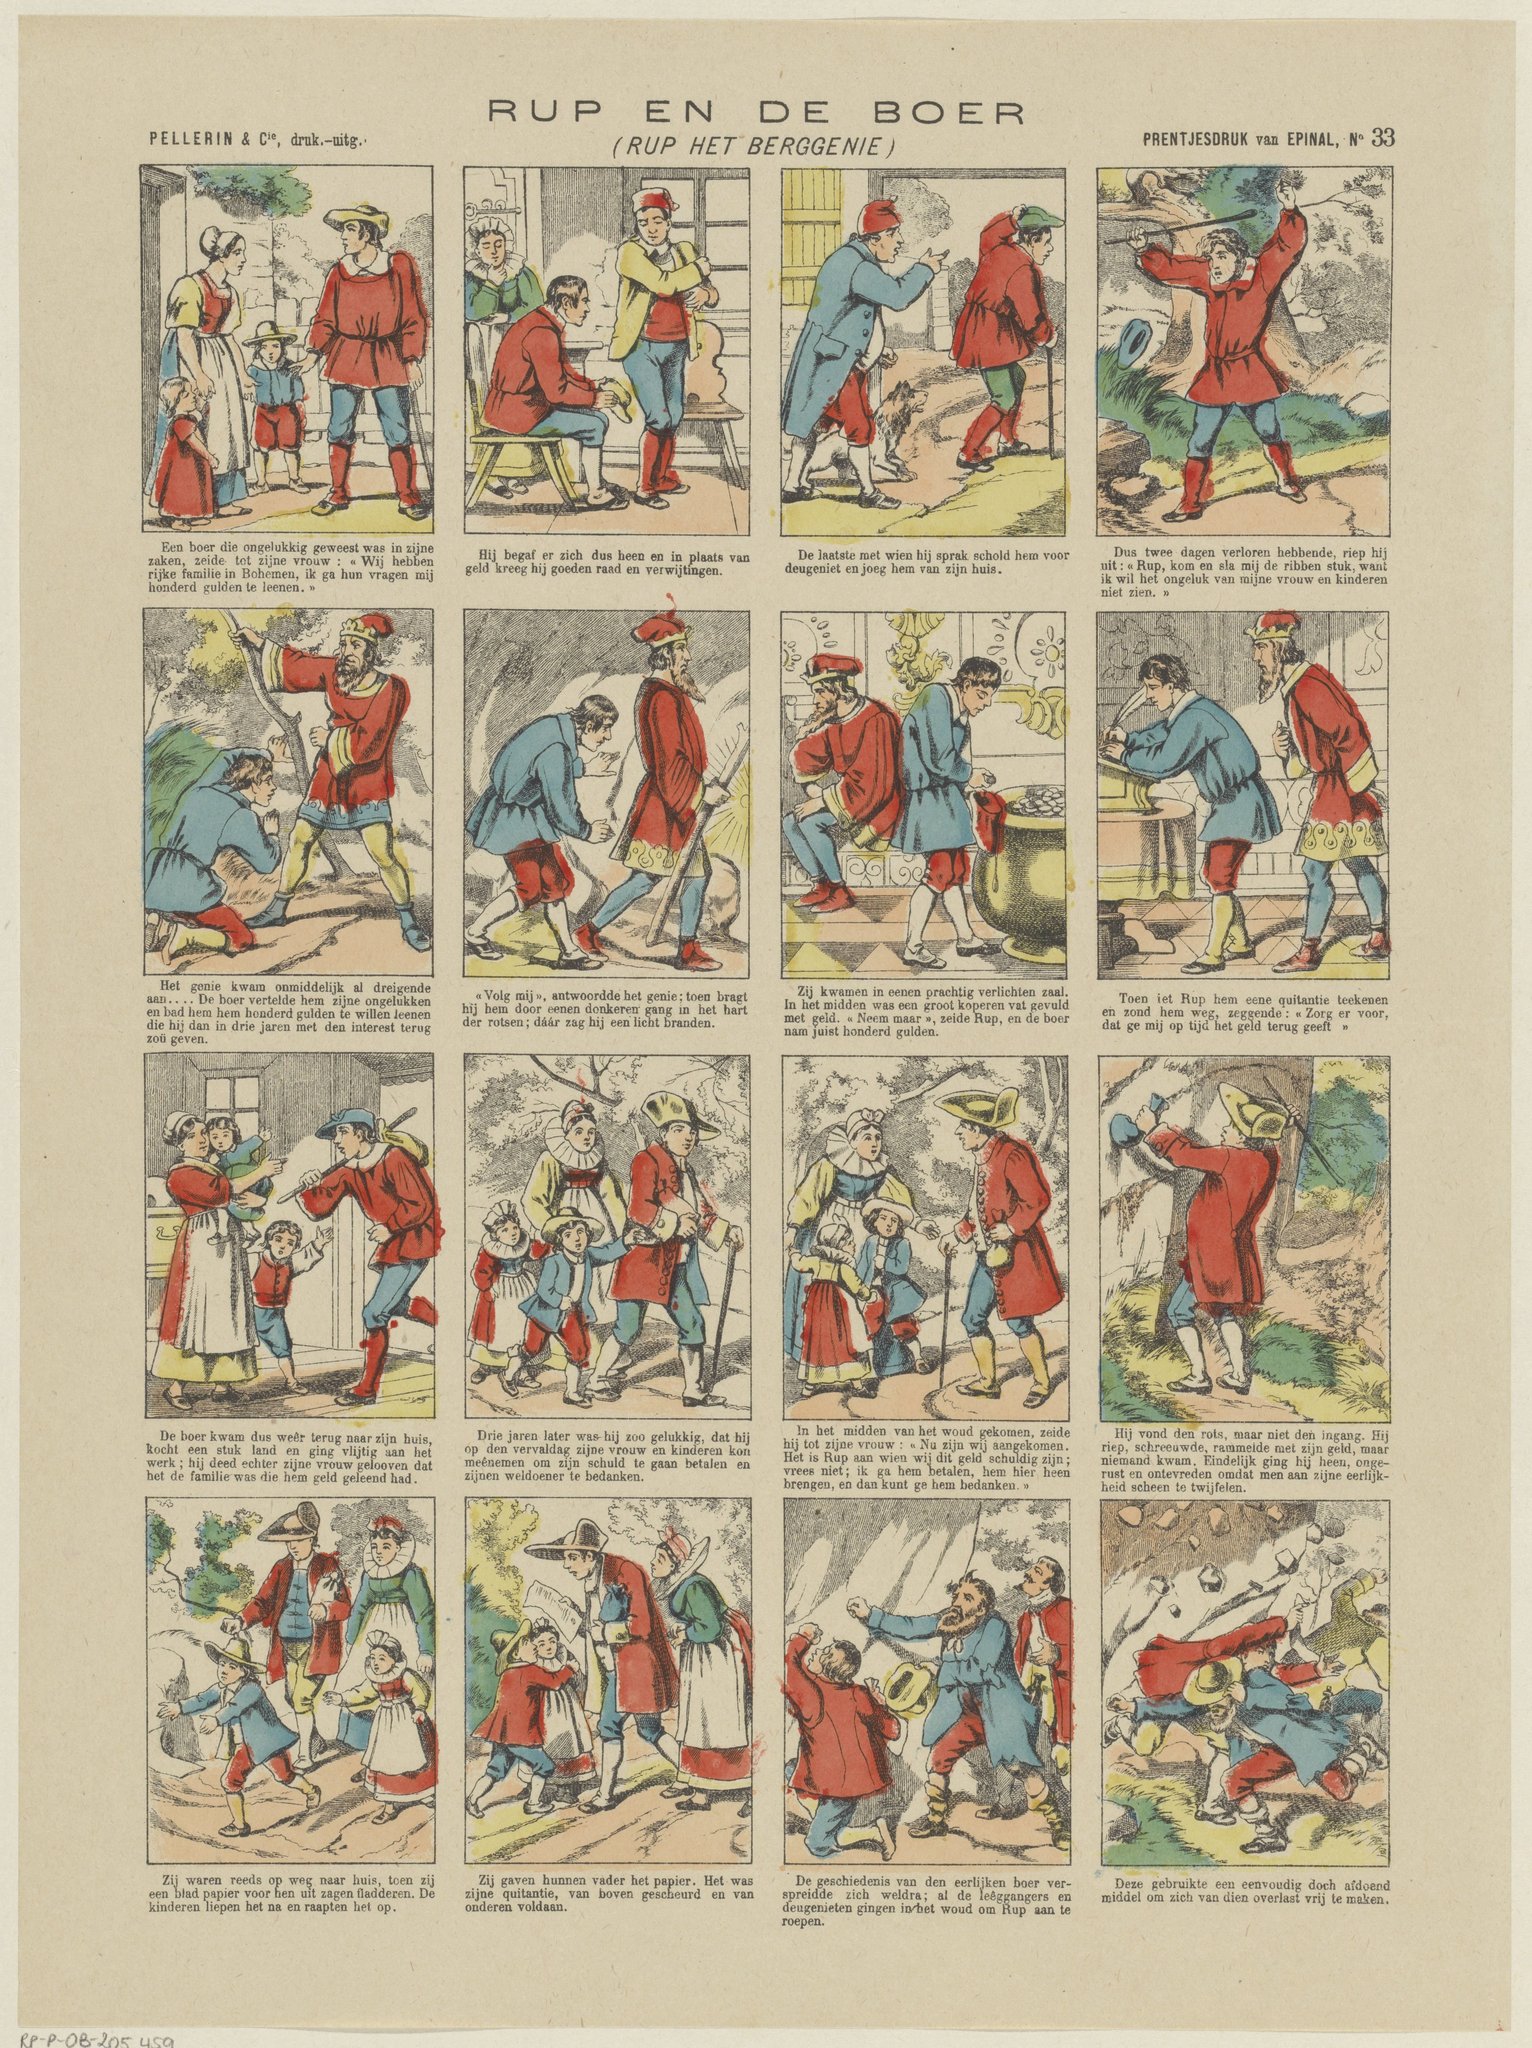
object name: popular print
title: Prentjesdruk van Épinal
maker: Anonymous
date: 1902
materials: paper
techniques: colour, letterpress printing, lithograph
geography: epinal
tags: good behaviour, money-lender, usurer, tales and fairy tales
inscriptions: collector's mark: Lugt 2760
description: Blad met 16 voorstellingen van een boer die geld leent van een geest. Onder elke afbeelding een onderschrift. Genummerd rechtsboven: No 33.